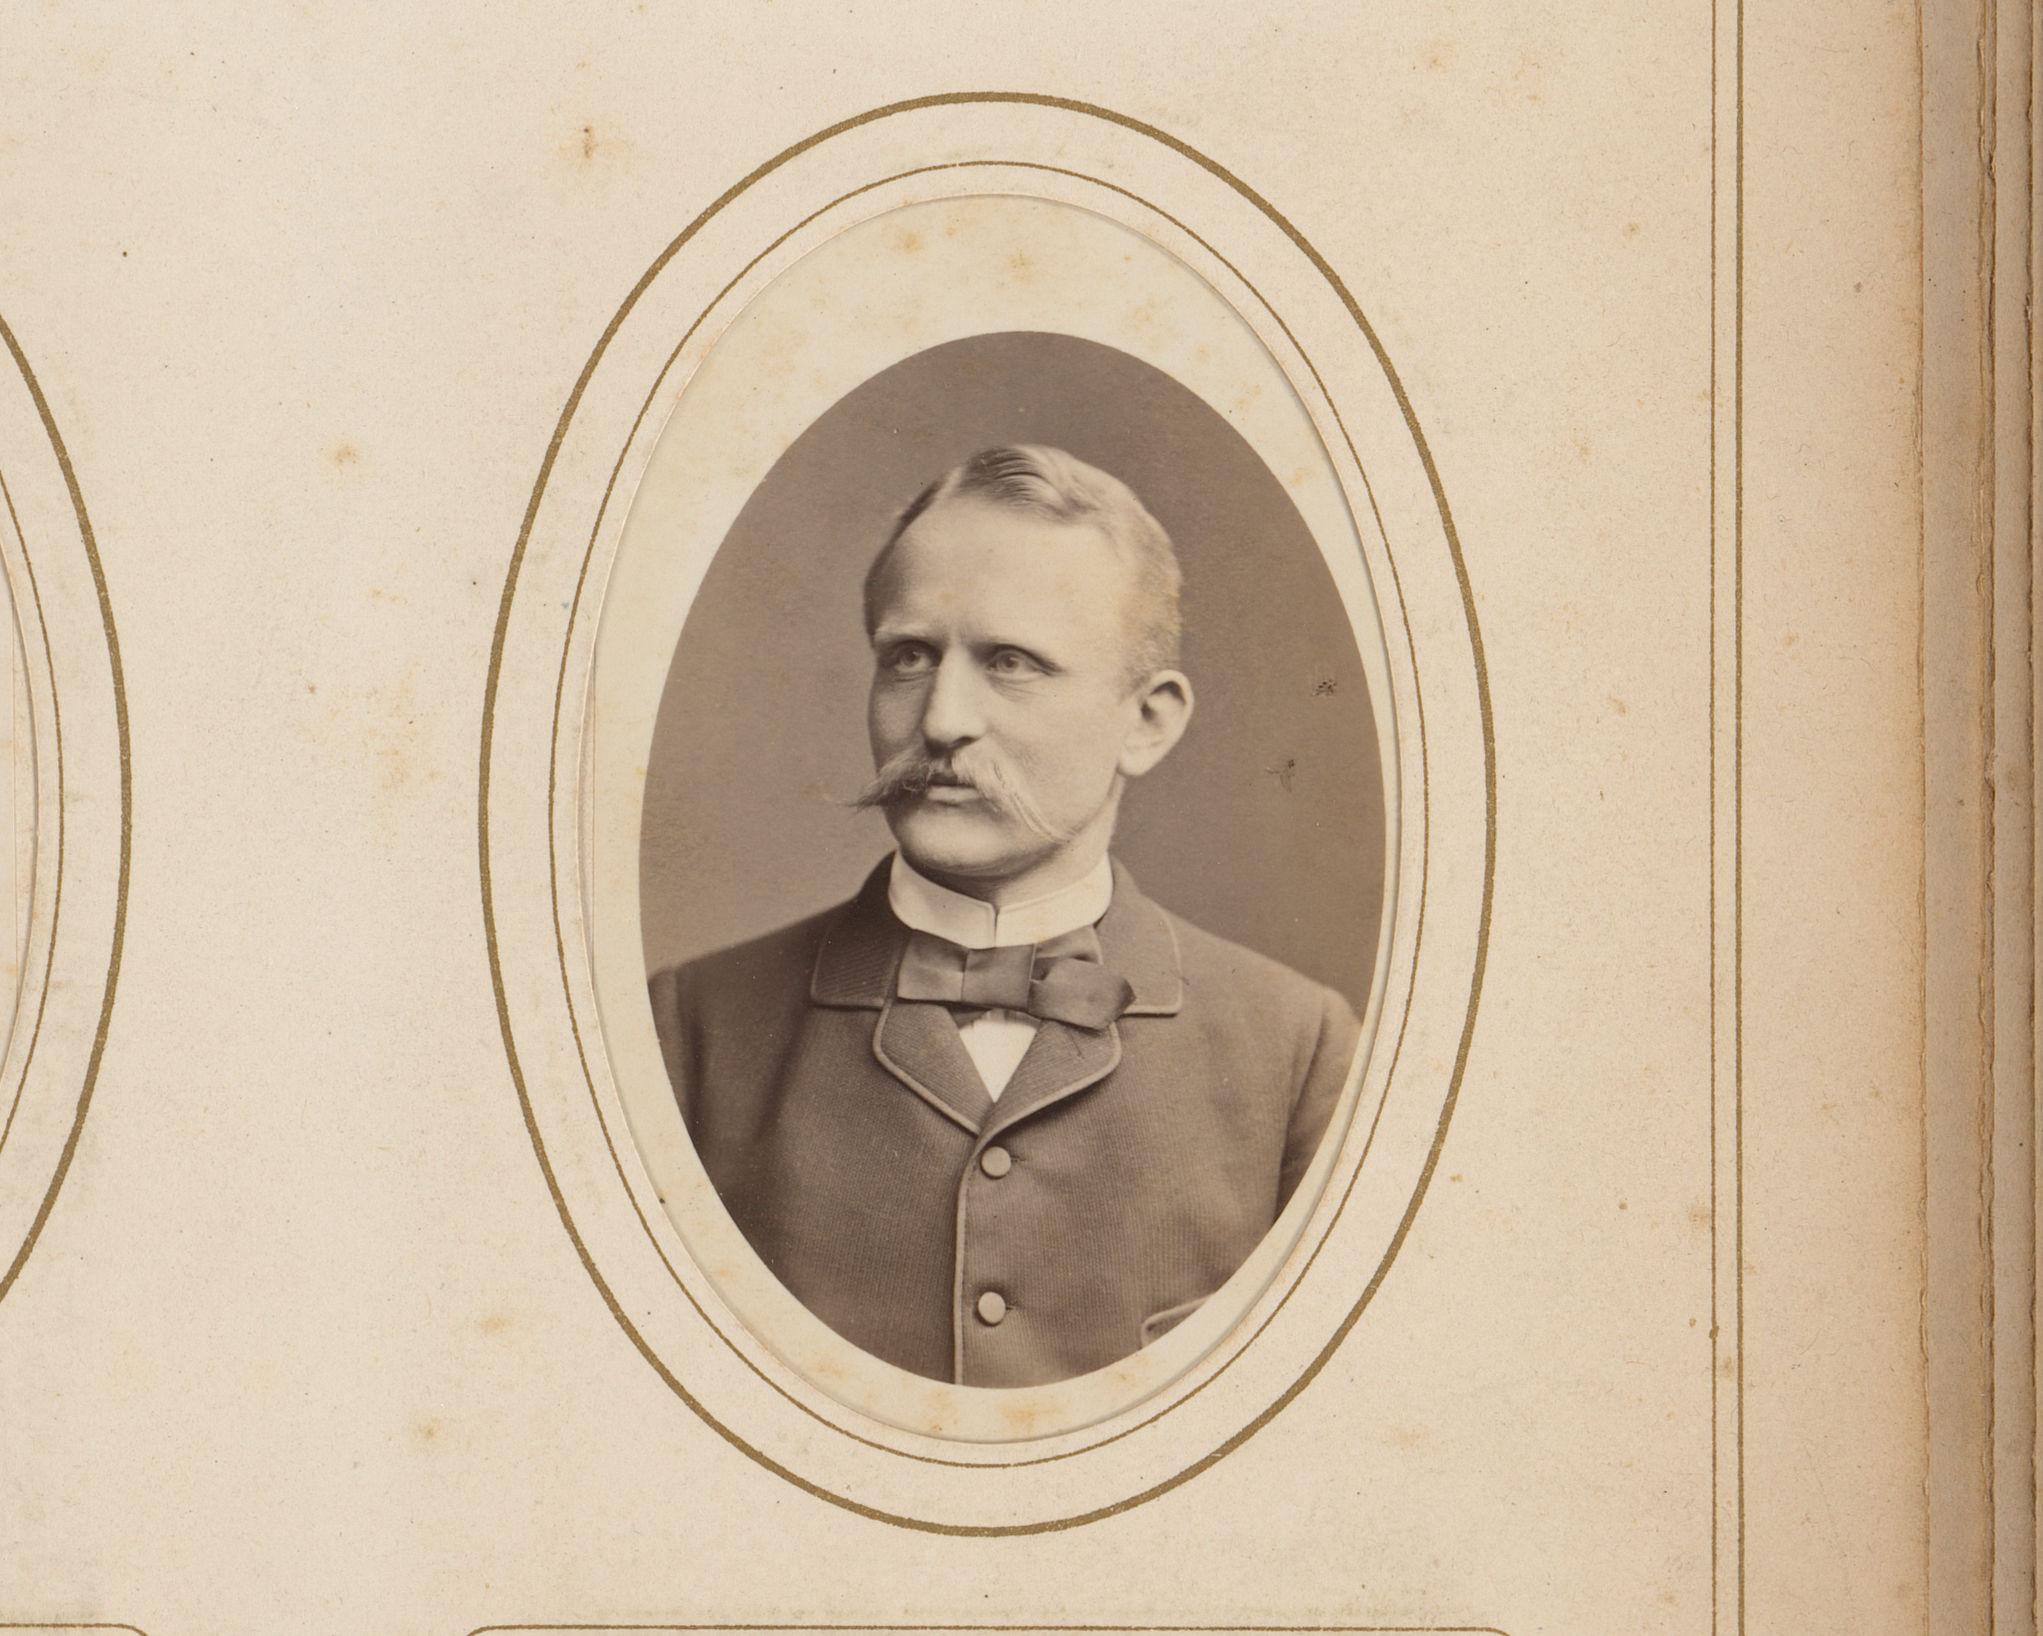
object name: photograph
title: Portret van een man met snor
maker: theodor prümm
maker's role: fotograaf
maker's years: 1841-1890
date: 1879-1900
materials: cardboard, photographic support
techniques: albumen print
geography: amsterdam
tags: moustache, historical persons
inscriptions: inscription: ‘Inhaber der Preismedaillen/ WIEN/ 1873./ BERLIN/ 1865./ HAMBURG/ 1868./ THEODOR PRÜMM/ BERLIN/ Unter den Linden 51./ 1879./ Platten werden aufbewahrt’